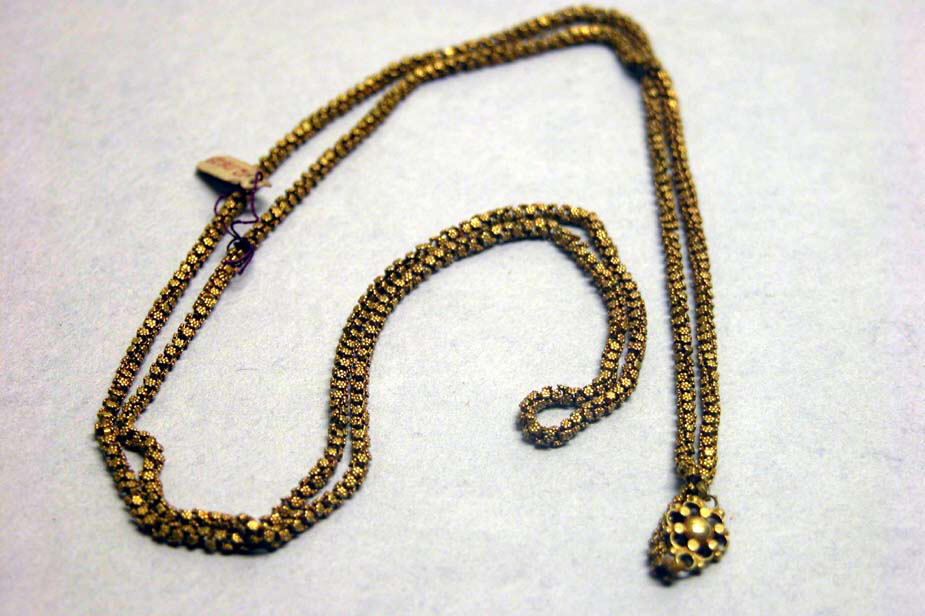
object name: necklace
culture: filipino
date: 1601-1900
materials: gold